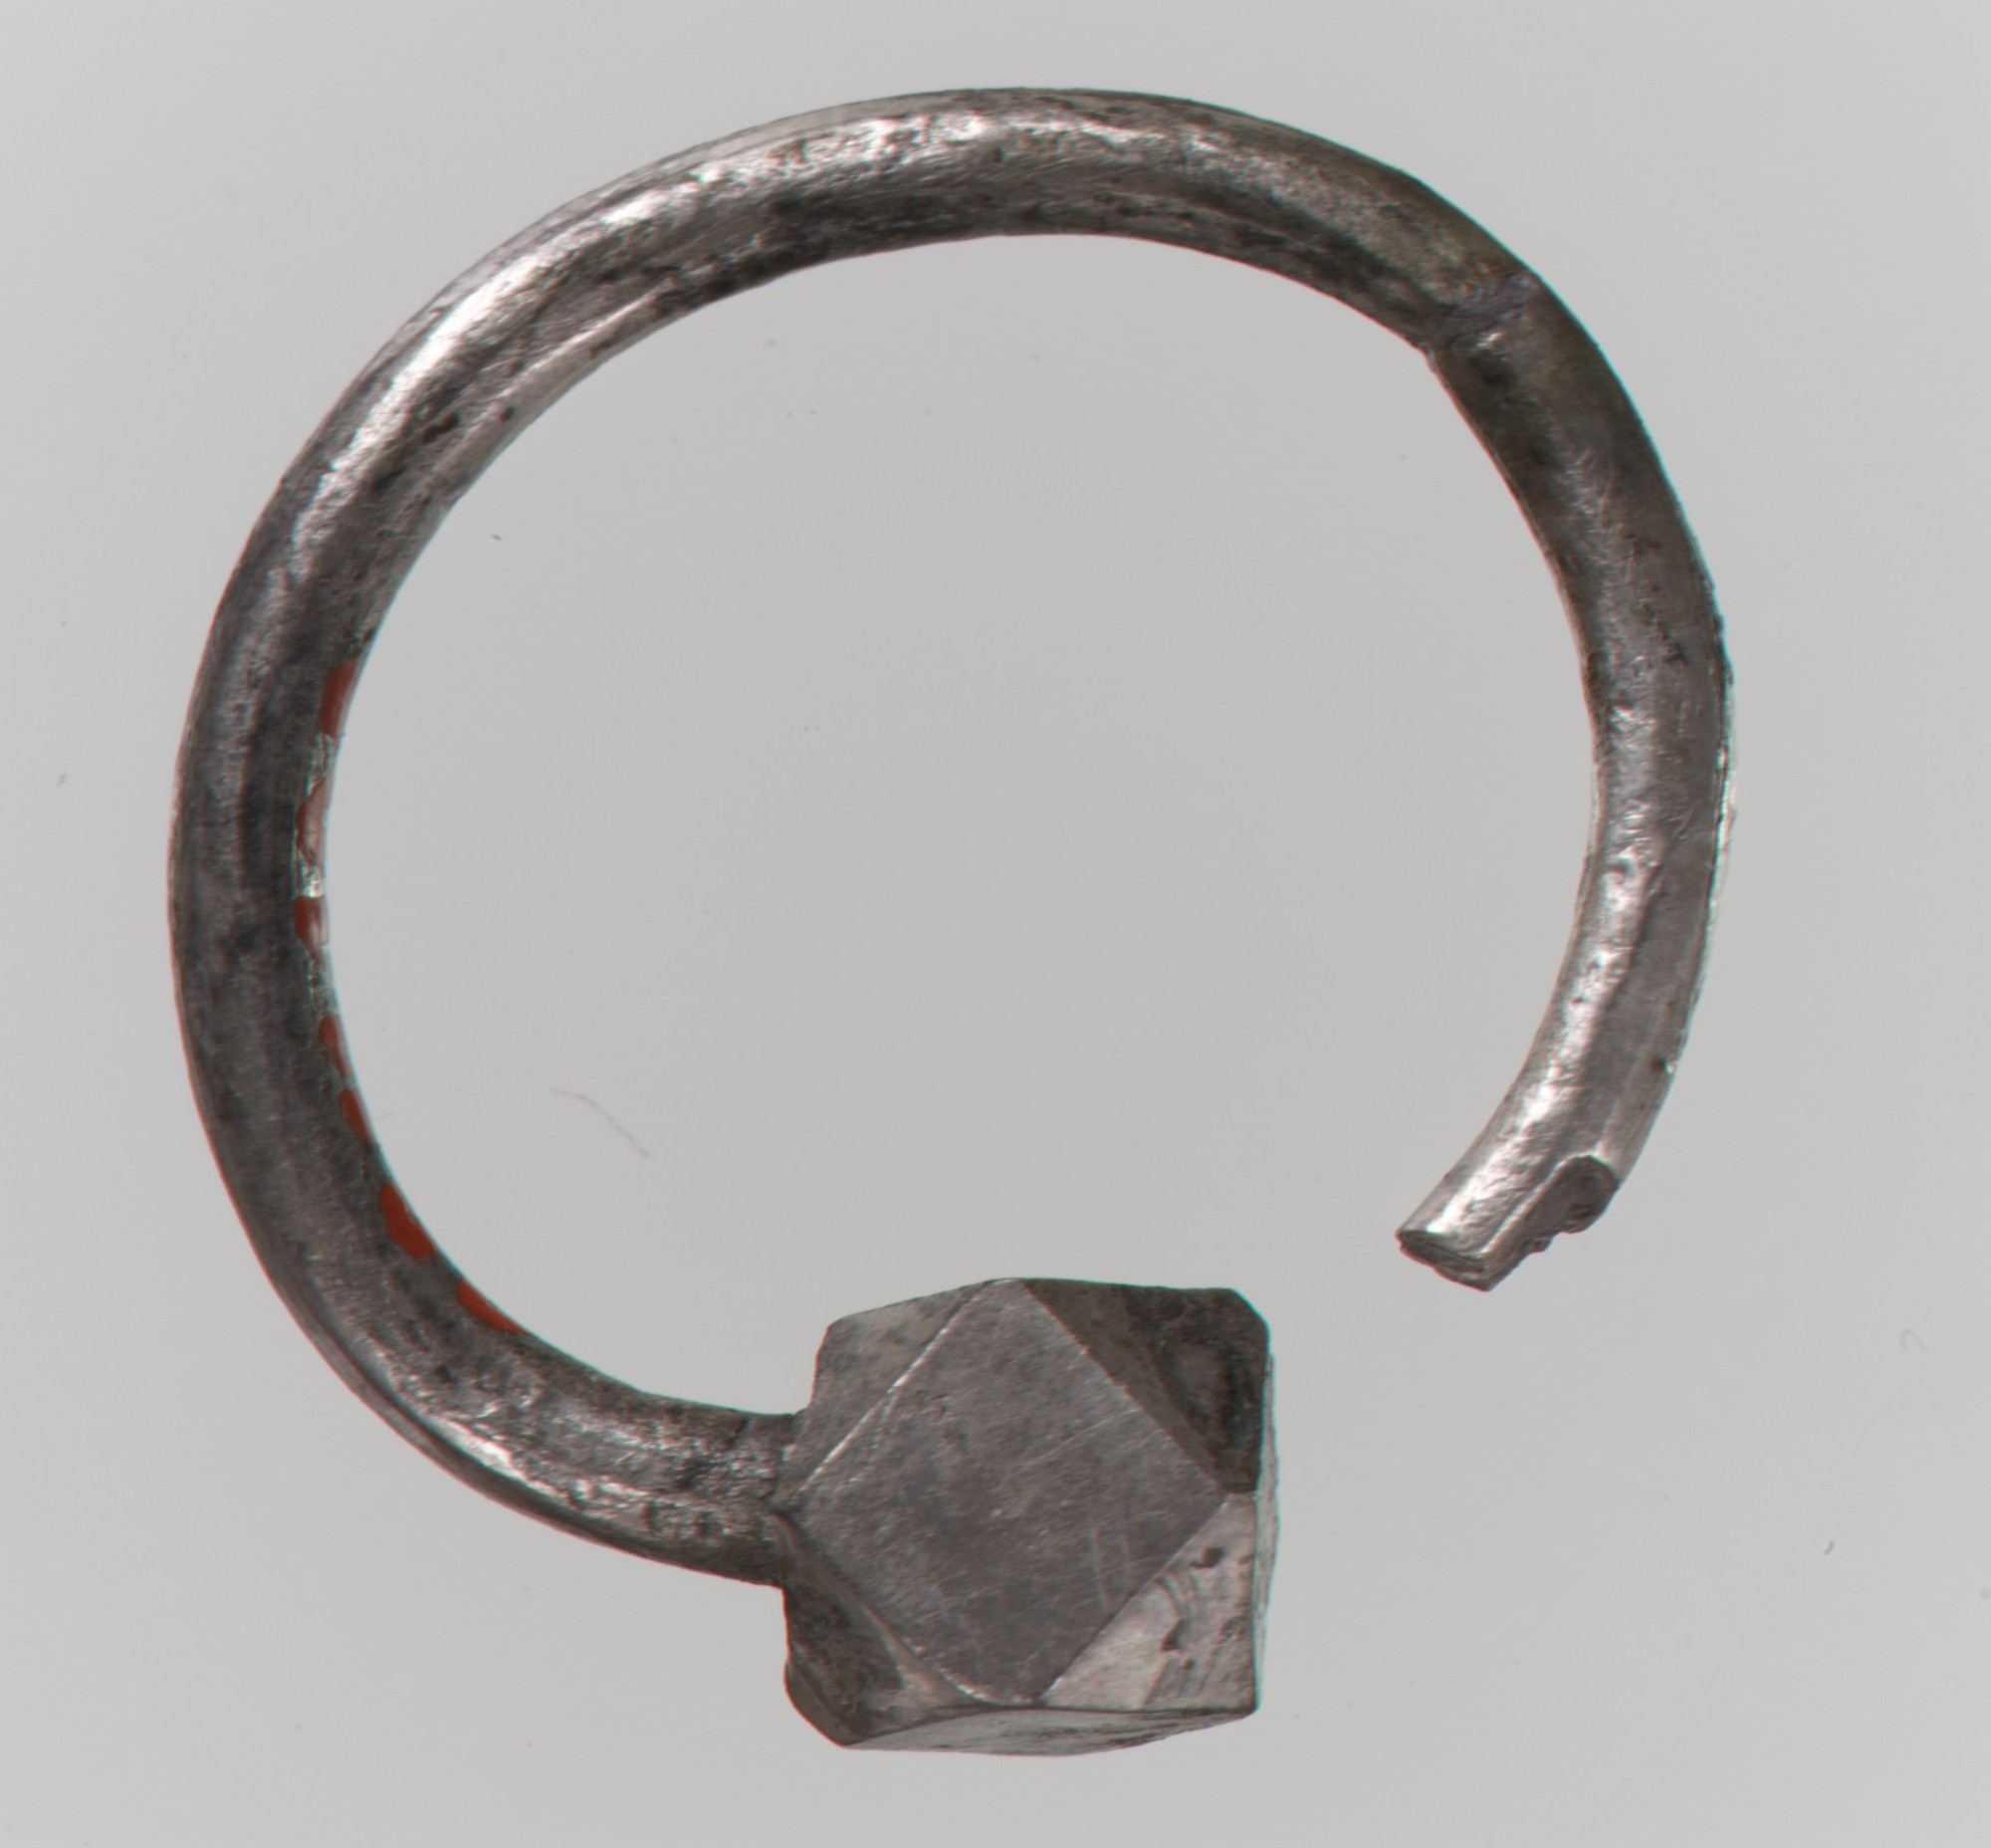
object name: earring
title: Silver Earring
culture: ostrogothic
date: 401-600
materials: silver